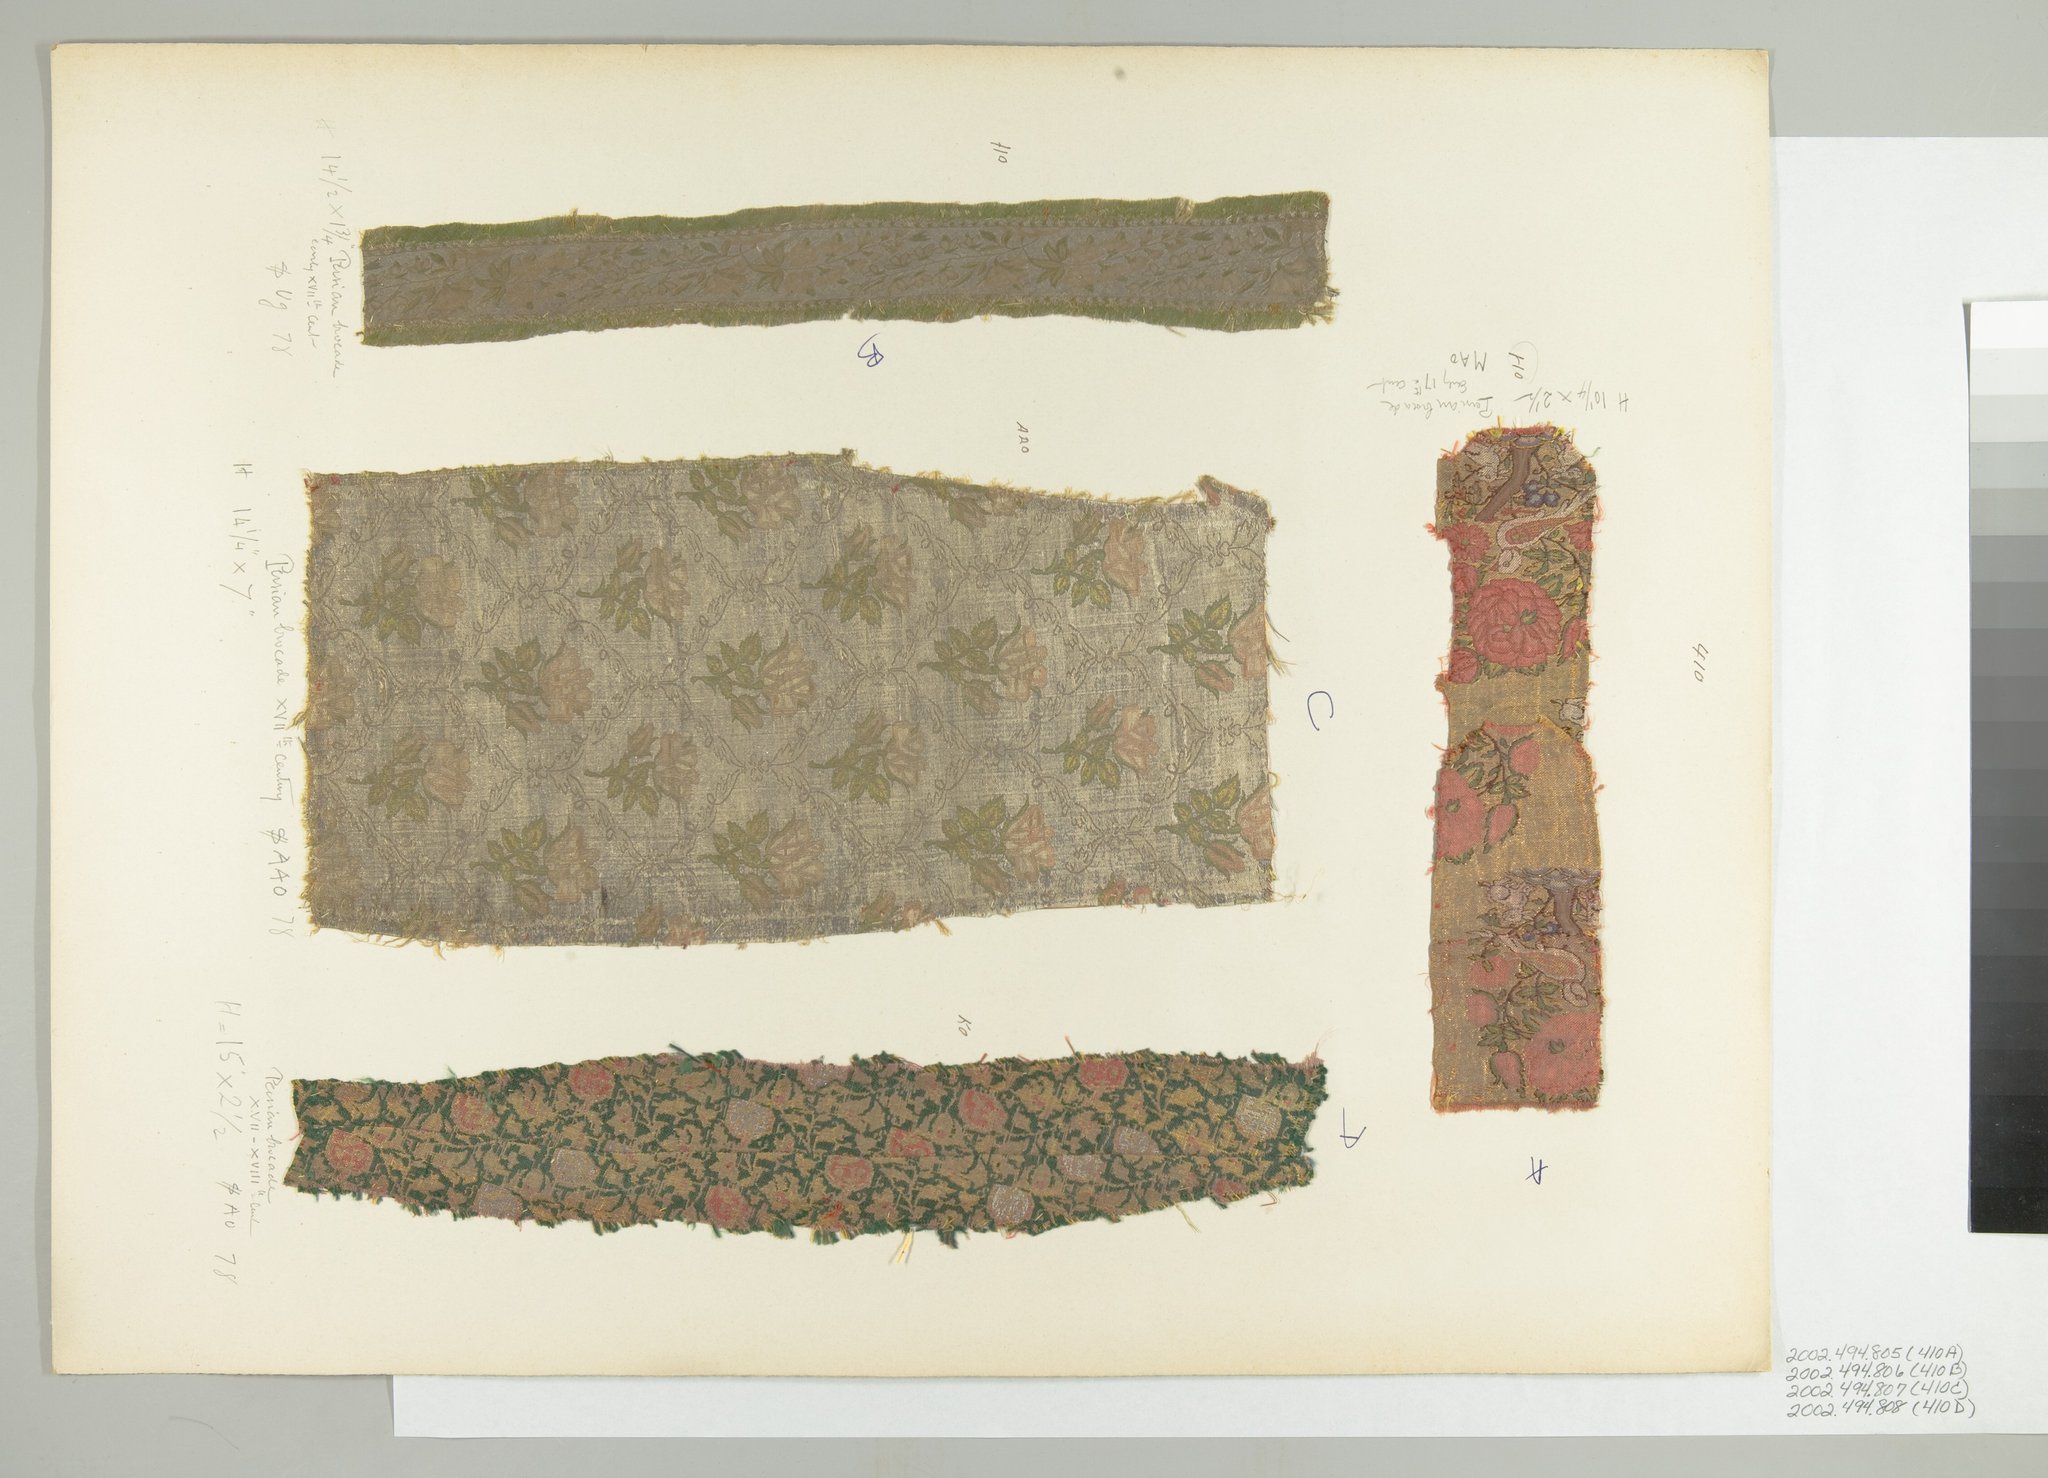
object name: textile fragment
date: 1601-1800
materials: metal thread, silk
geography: iran